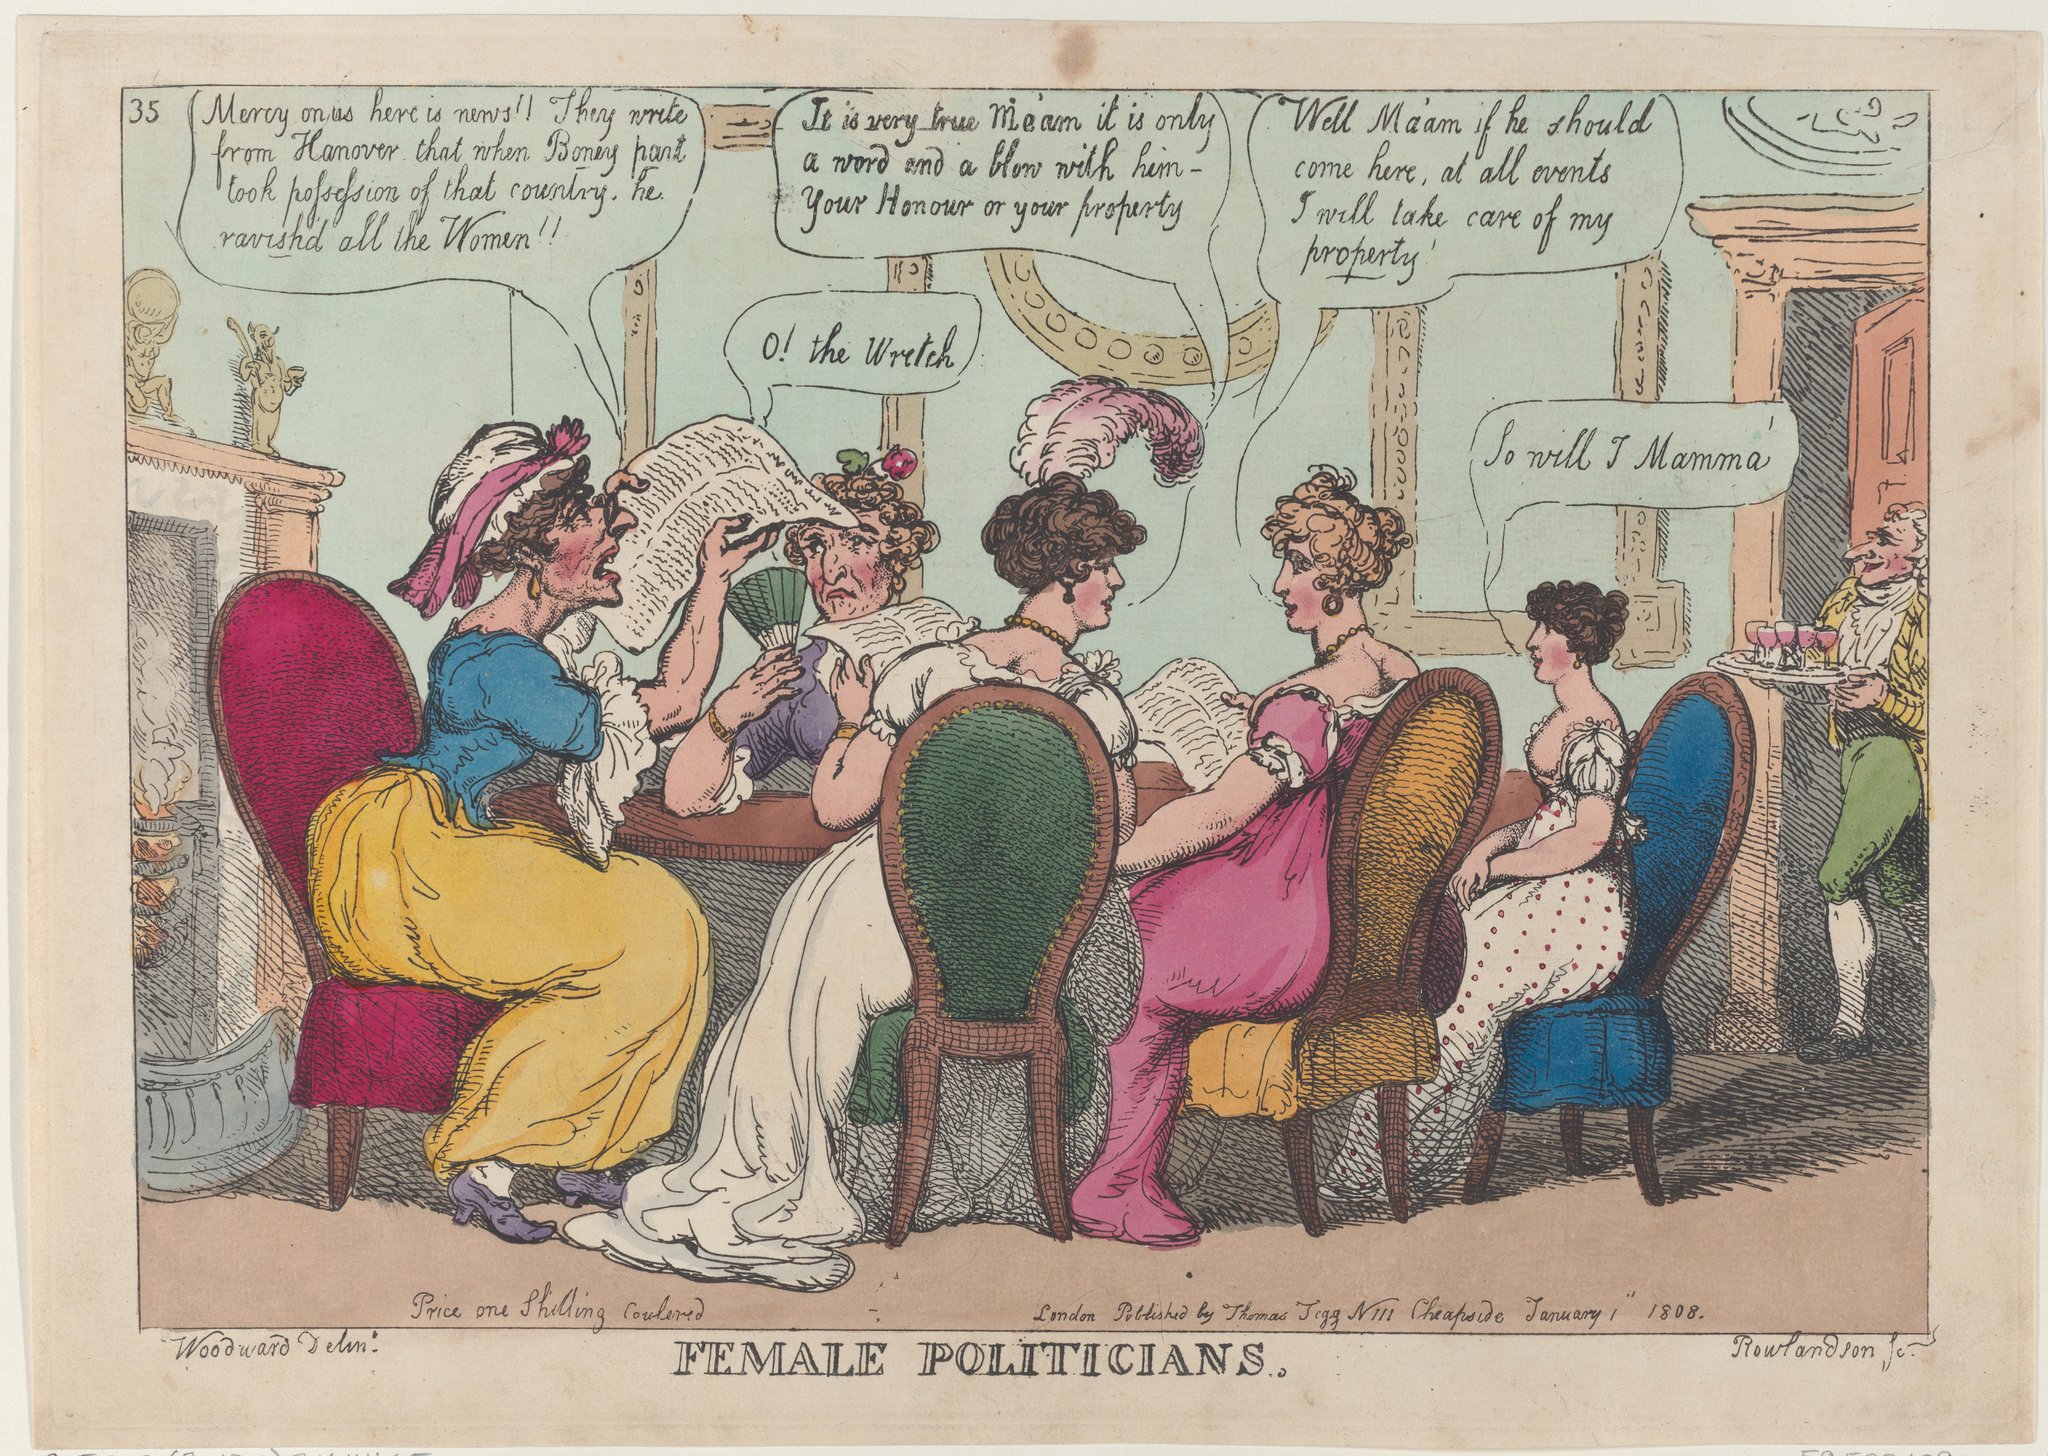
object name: print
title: Female Politicians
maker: thomas rowlandson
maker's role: artist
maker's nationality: british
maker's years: 1757-1827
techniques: etching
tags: satire,women,reading